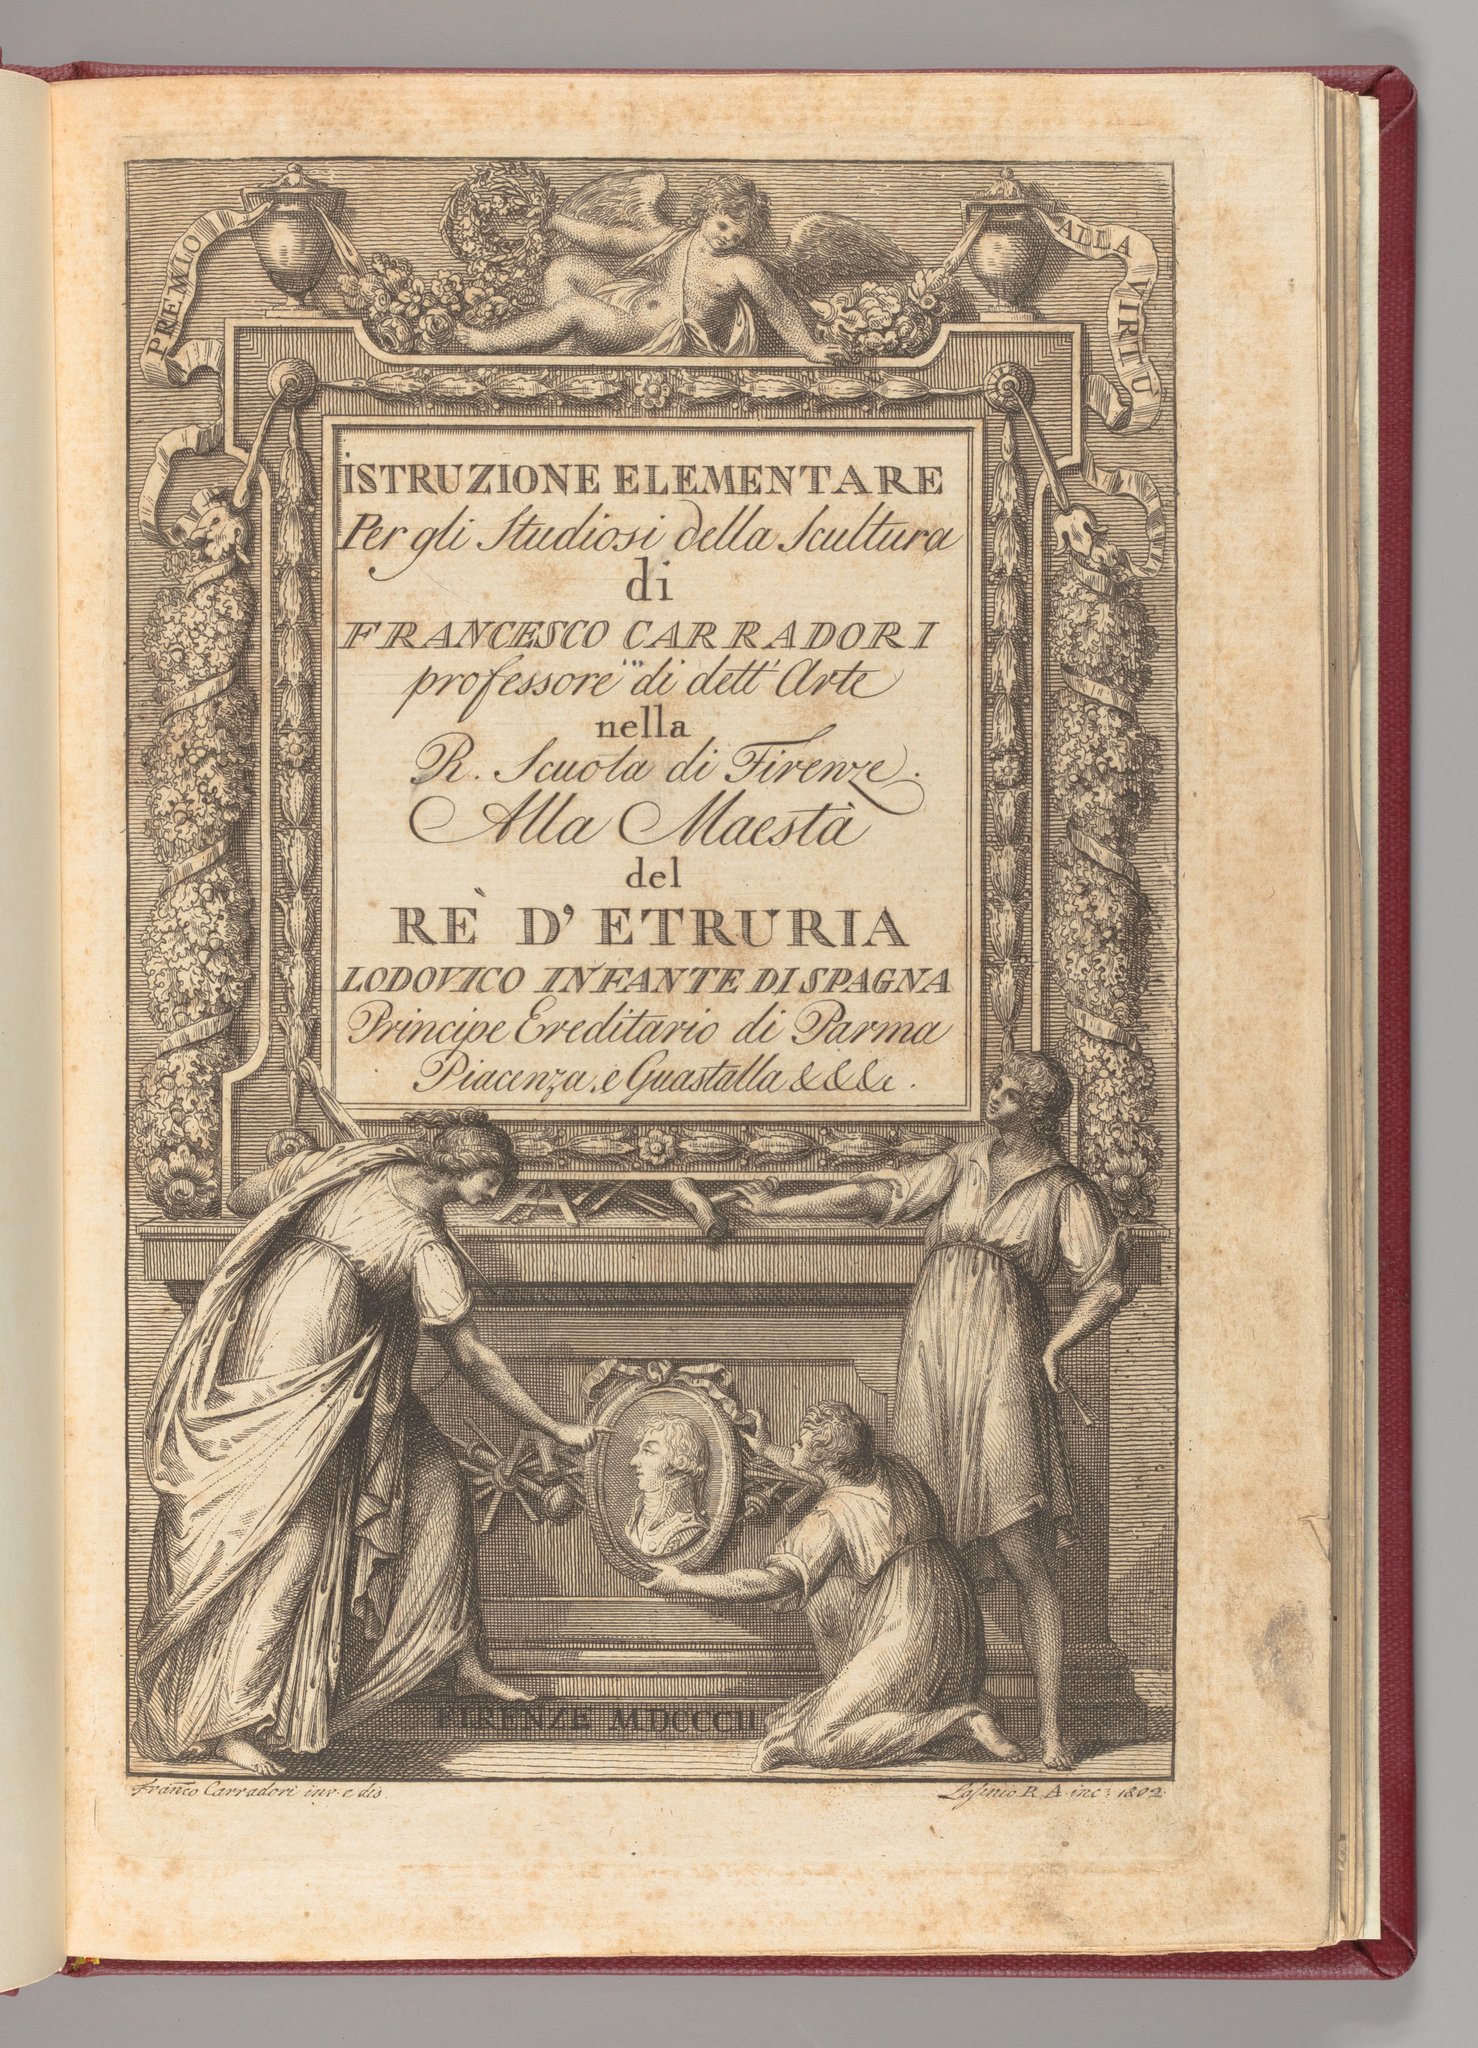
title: Istruzione elementare per gli studiosi della scultura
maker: francesco carradori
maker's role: author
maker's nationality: italian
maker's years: 1747-1825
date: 1802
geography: italy